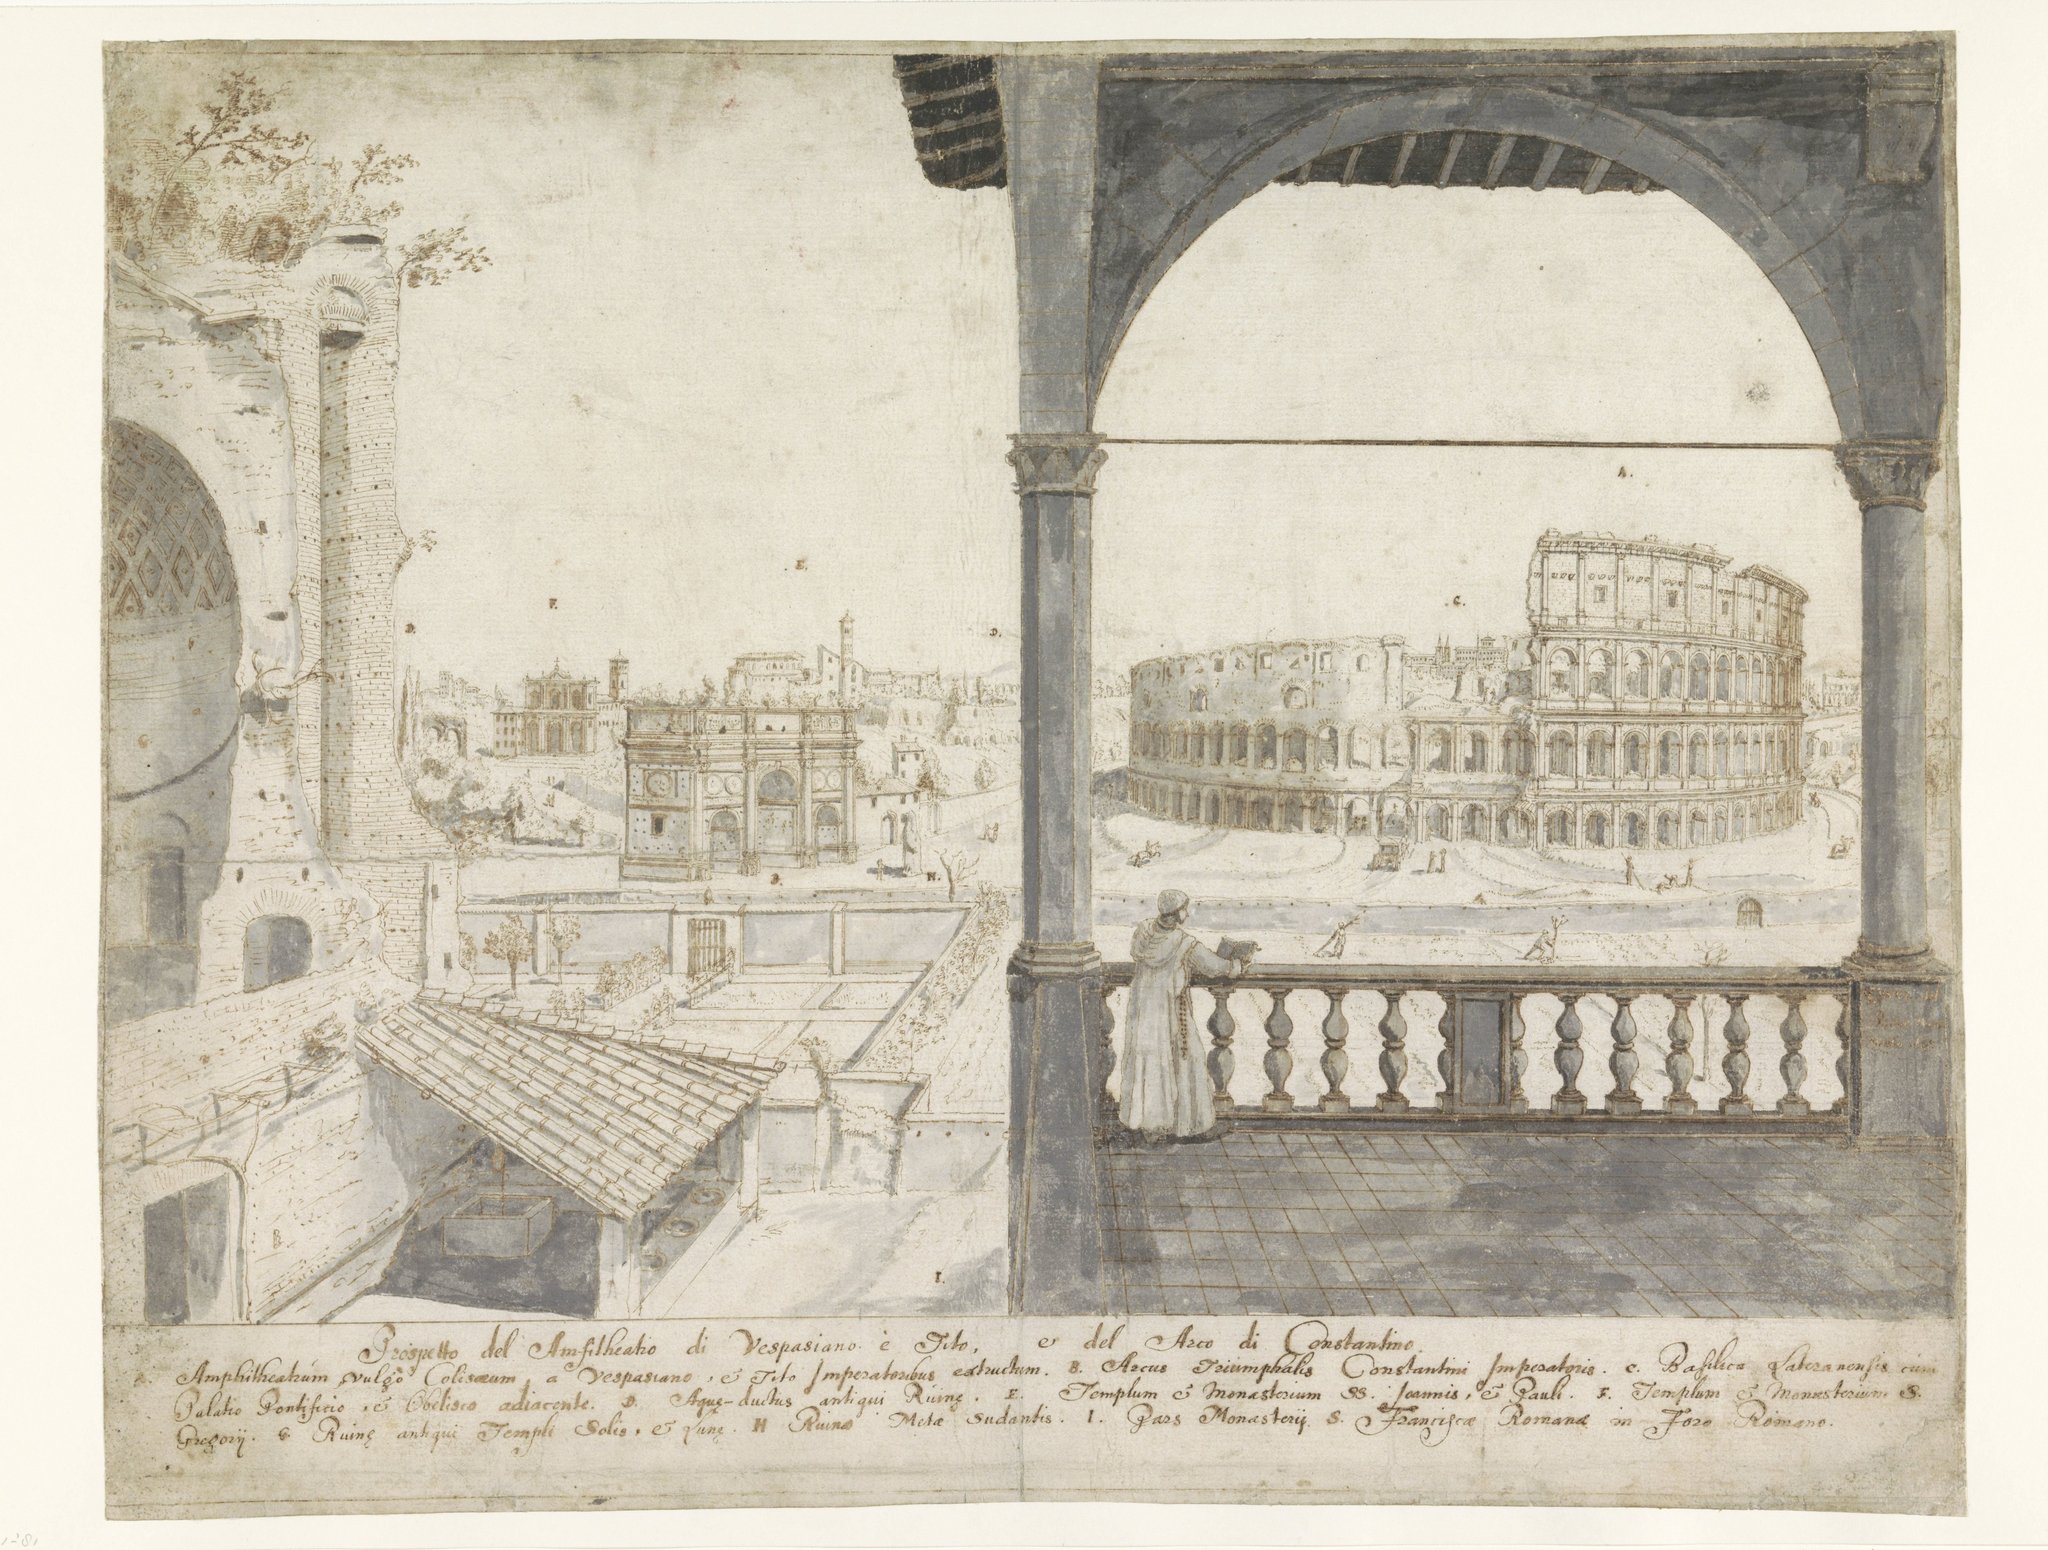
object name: design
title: Gezicht te Rome op het Colosseum en de boog van Constantijn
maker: lievin cruyl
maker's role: draughtsman, print maker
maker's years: 1634-1720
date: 1664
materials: ink, paper, pencil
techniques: brush, pen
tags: amphitheatre, public road, rome, arch of constantine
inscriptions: : ‘Prospetto del Amfitheatro di Vespano e Tito, e del Arco di Constantino’, date: ‘1664’